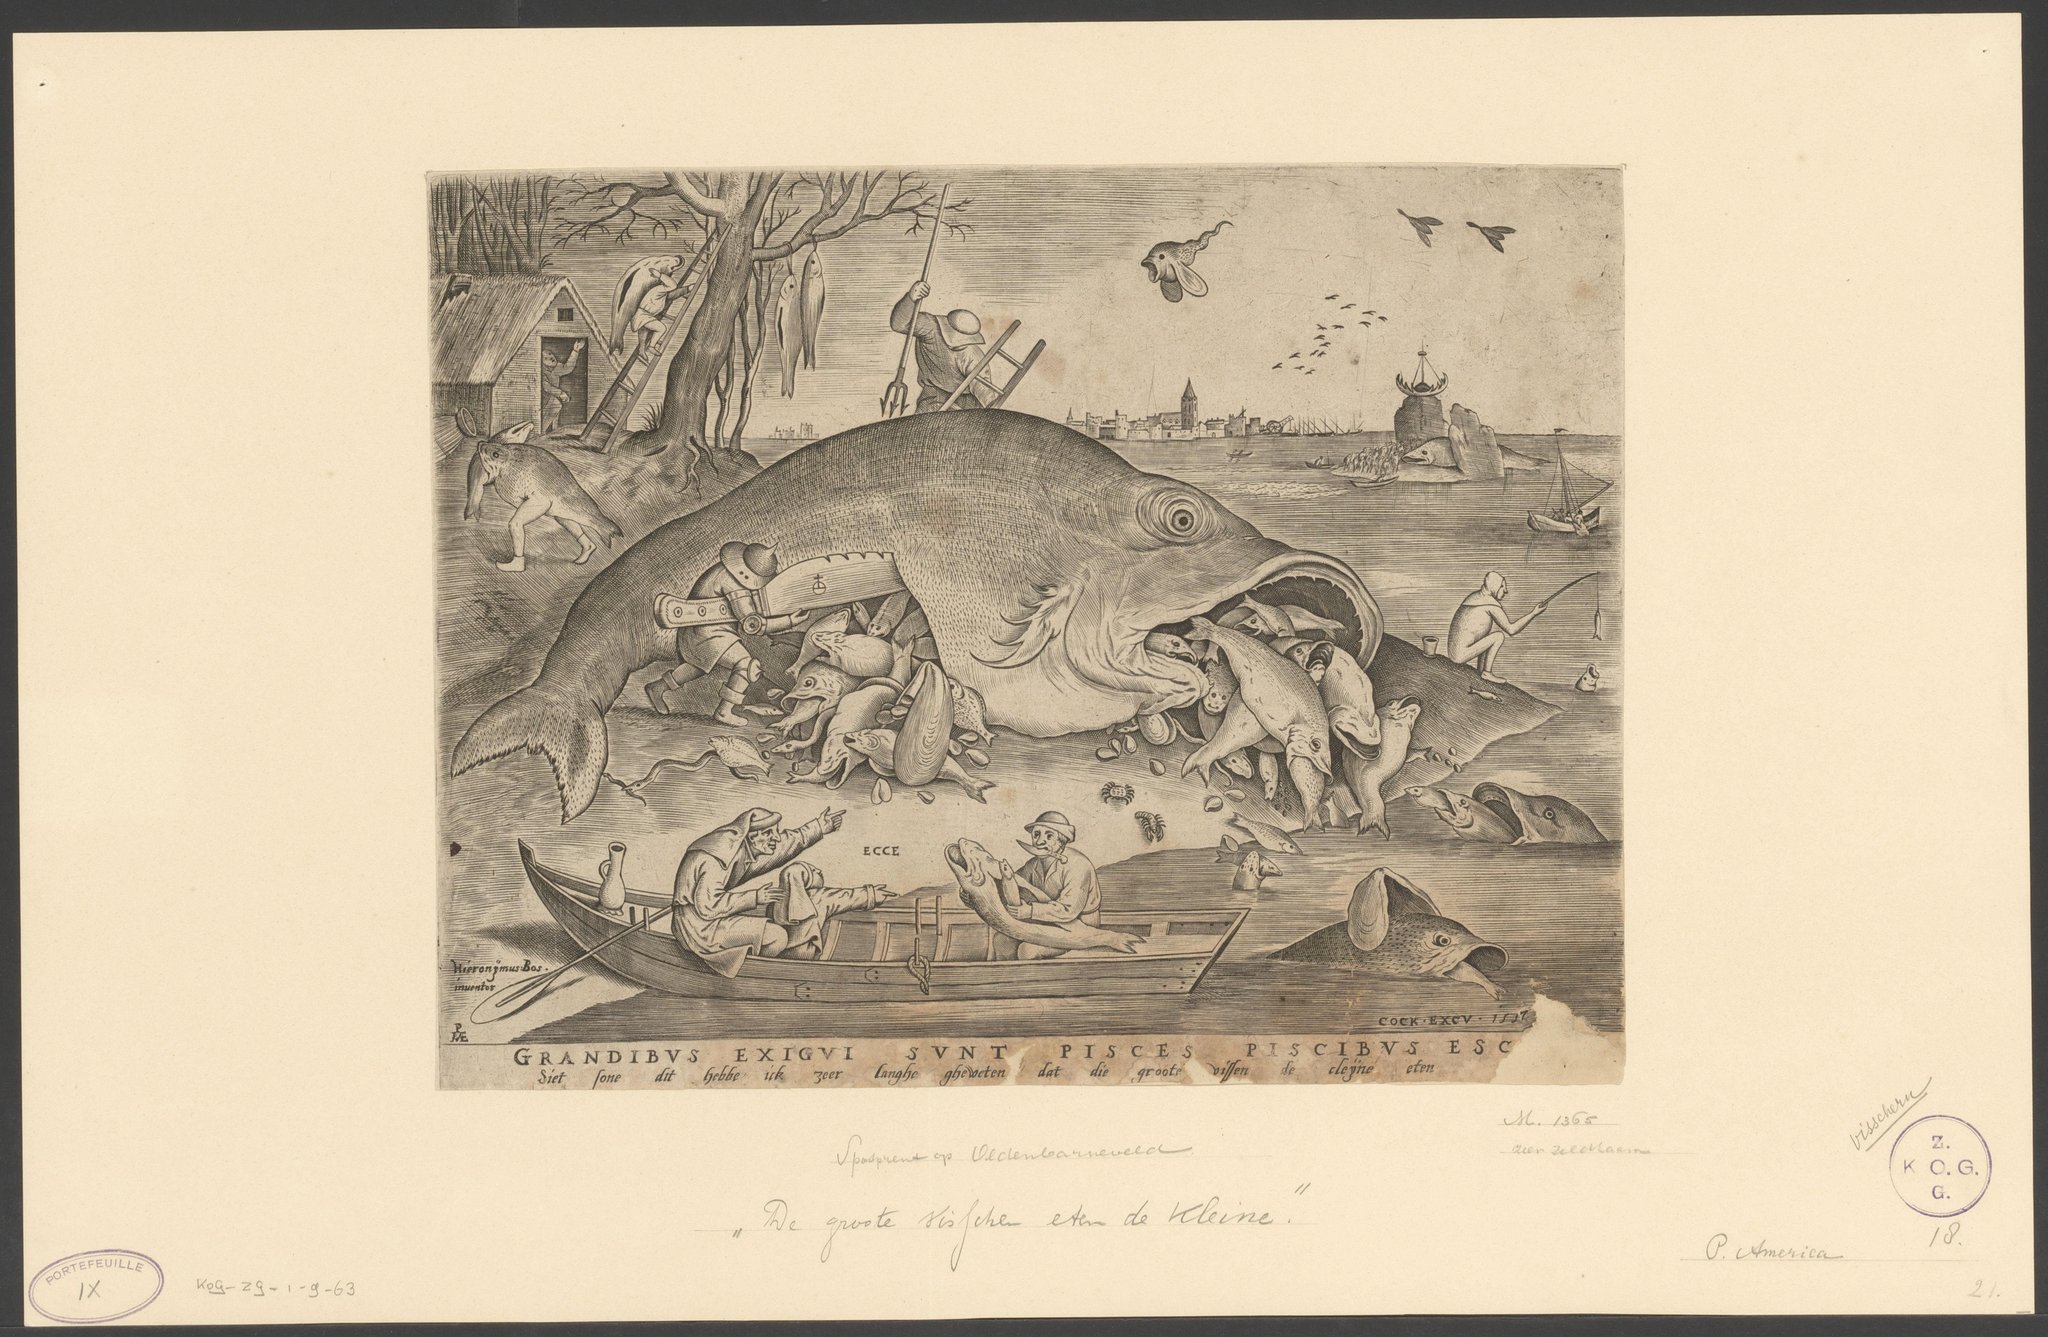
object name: print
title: Grote vissen eten kleine vissen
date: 1557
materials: paper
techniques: engraving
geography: antwerp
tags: monsters larger than normal, fish; still life of fishes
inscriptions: collector's mark: Lugt 1641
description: De grote vissen eten de kleine vissen. Een grote vis die gevangen op de oever ligt wordt door een mannetje met een mes opengesneden waardoor vele kleine vissen en schelpen uit de buik en bek tevoorschijn komen. Op de voorgrond een roeibootje waarin een vader zijn zoon op het schouwspel wijst en een visser. Met onderschrift van een regel in het Latijn en een regel in het Nederlands. Onderwerpsrubrieken binnen de Atlas Zeden en Gewoonten: Handel, nijverheid en verkeer, Visscherij, Zee- en Riviervisscherij.